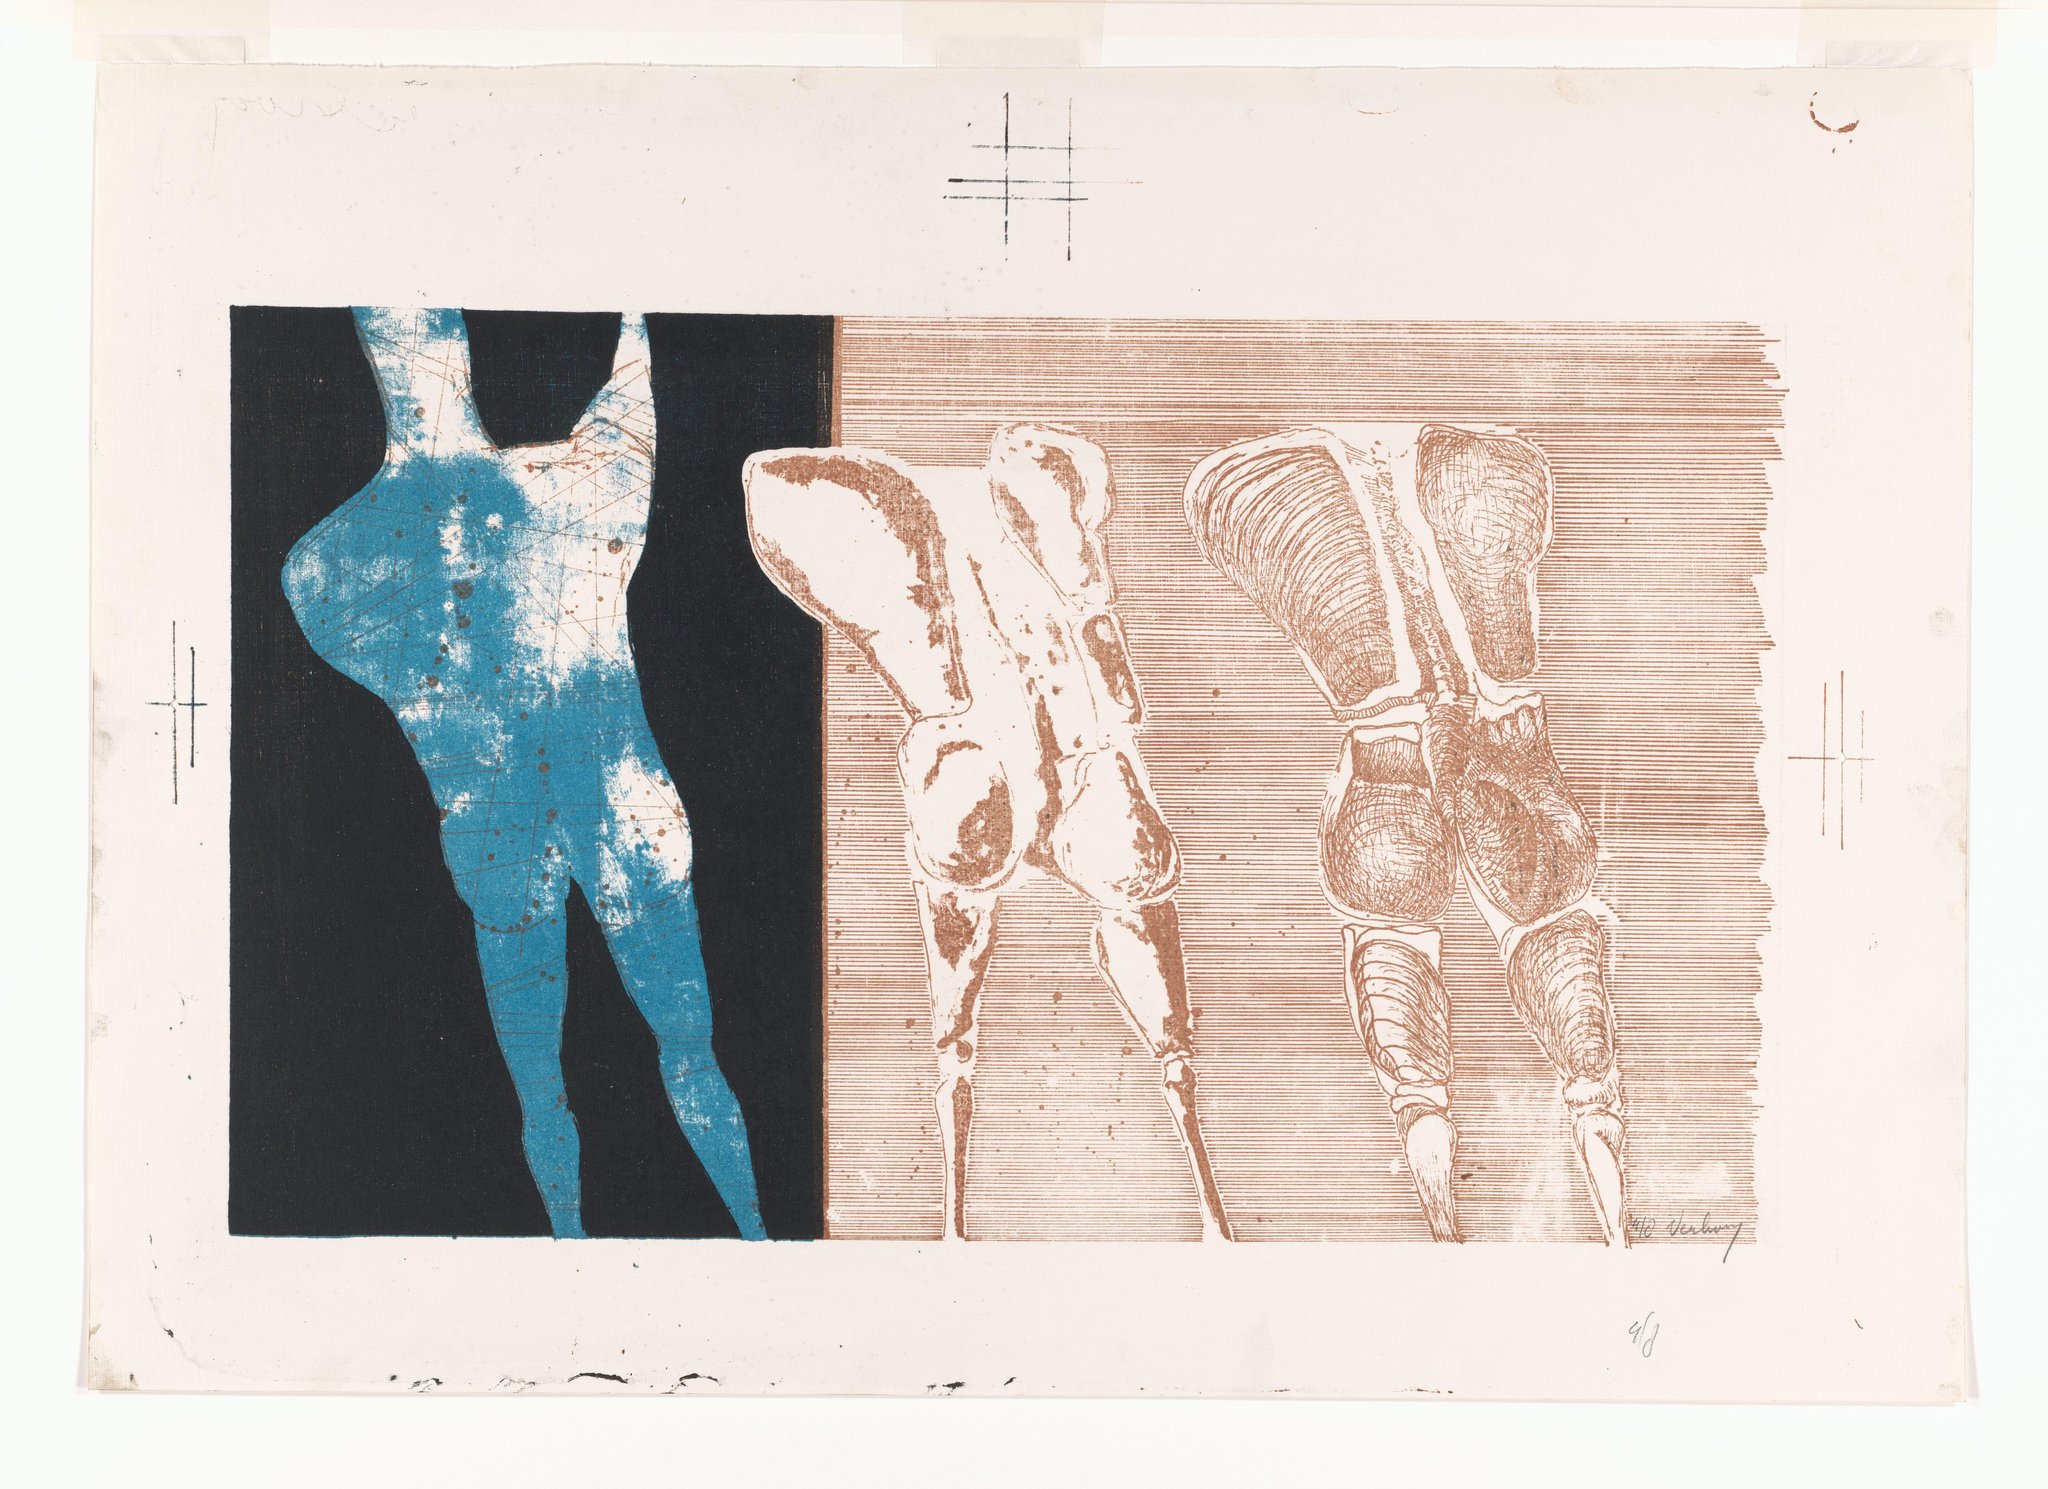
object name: print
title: Vluchtende figuren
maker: aat verhoog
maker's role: print maker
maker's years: 1933-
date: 1945-2006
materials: paper, ink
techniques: lithograph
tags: flight, running away; pursuing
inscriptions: edition: ‘4/8’, signature: ‘Aat Verhoog’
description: Drie gedeformeerde naakte rugfiguren; de linker in blauw tegen een zwart fond, de andere twee in bruin en wit.